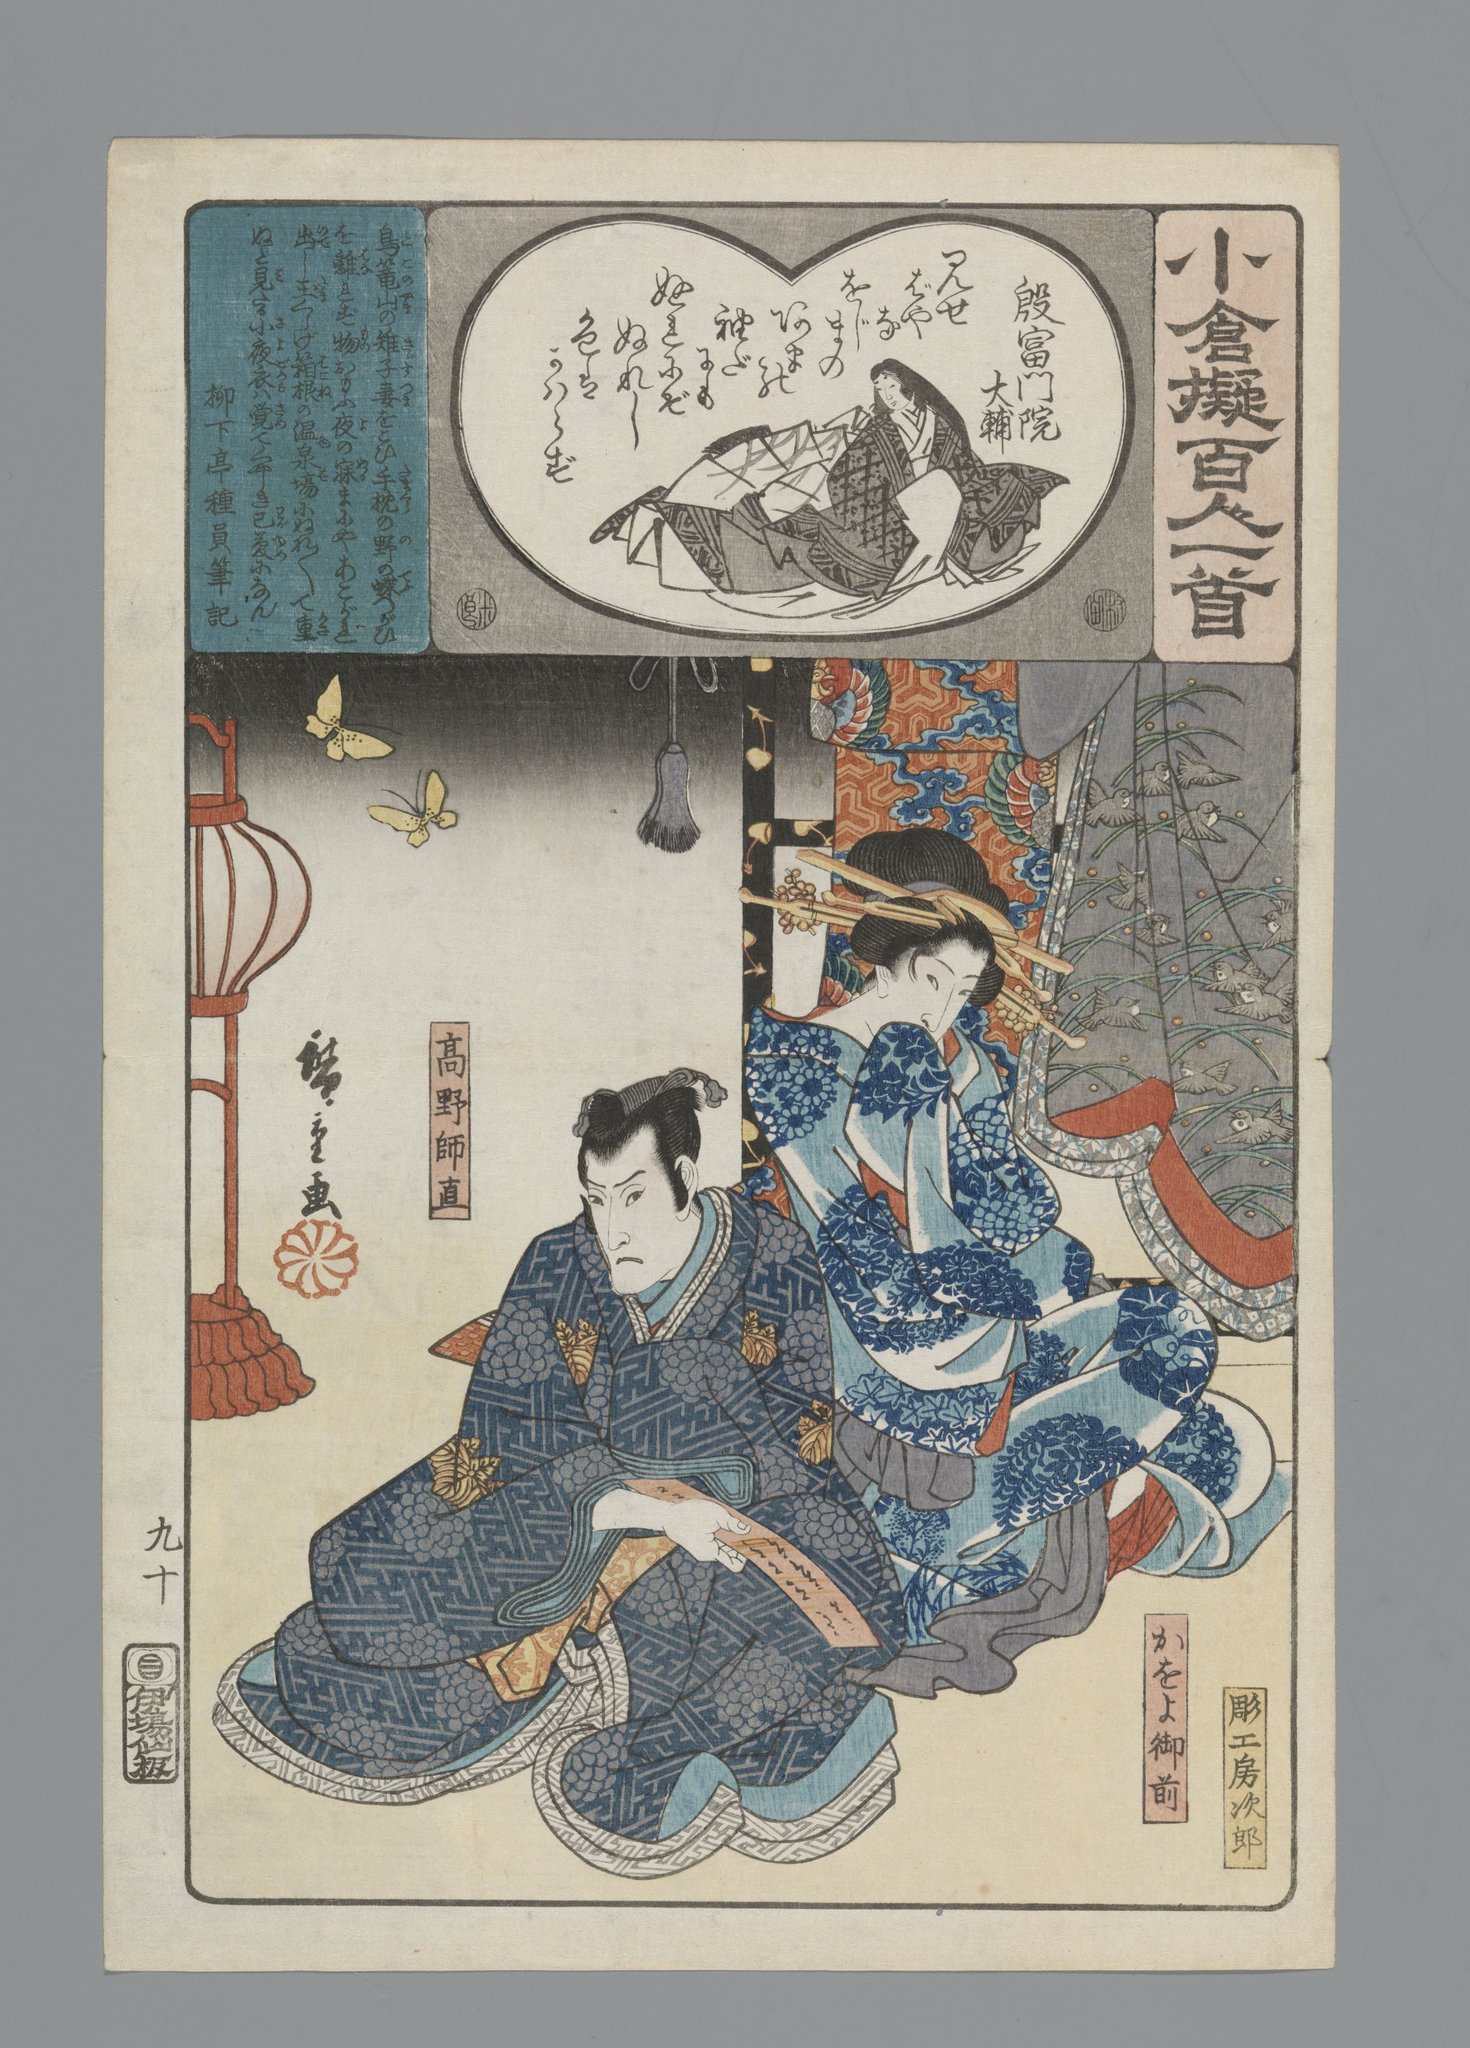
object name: print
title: Ogura Imitation of the One Hundred Poems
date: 1847-1850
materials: paper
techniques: woodcut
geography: japan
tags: group of actors, troupe; actors on the stage, lover with love-letter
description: Moronao met liefdesbrief voor de getrouwde Kaoyo achter hem. De vlinders staan voor echtelijke trouw en geven aan dat Kaoyo niet op de avances van Moronao in gaat. Scene uit een kabukitoneelstuk. Gedicht door Tayû.